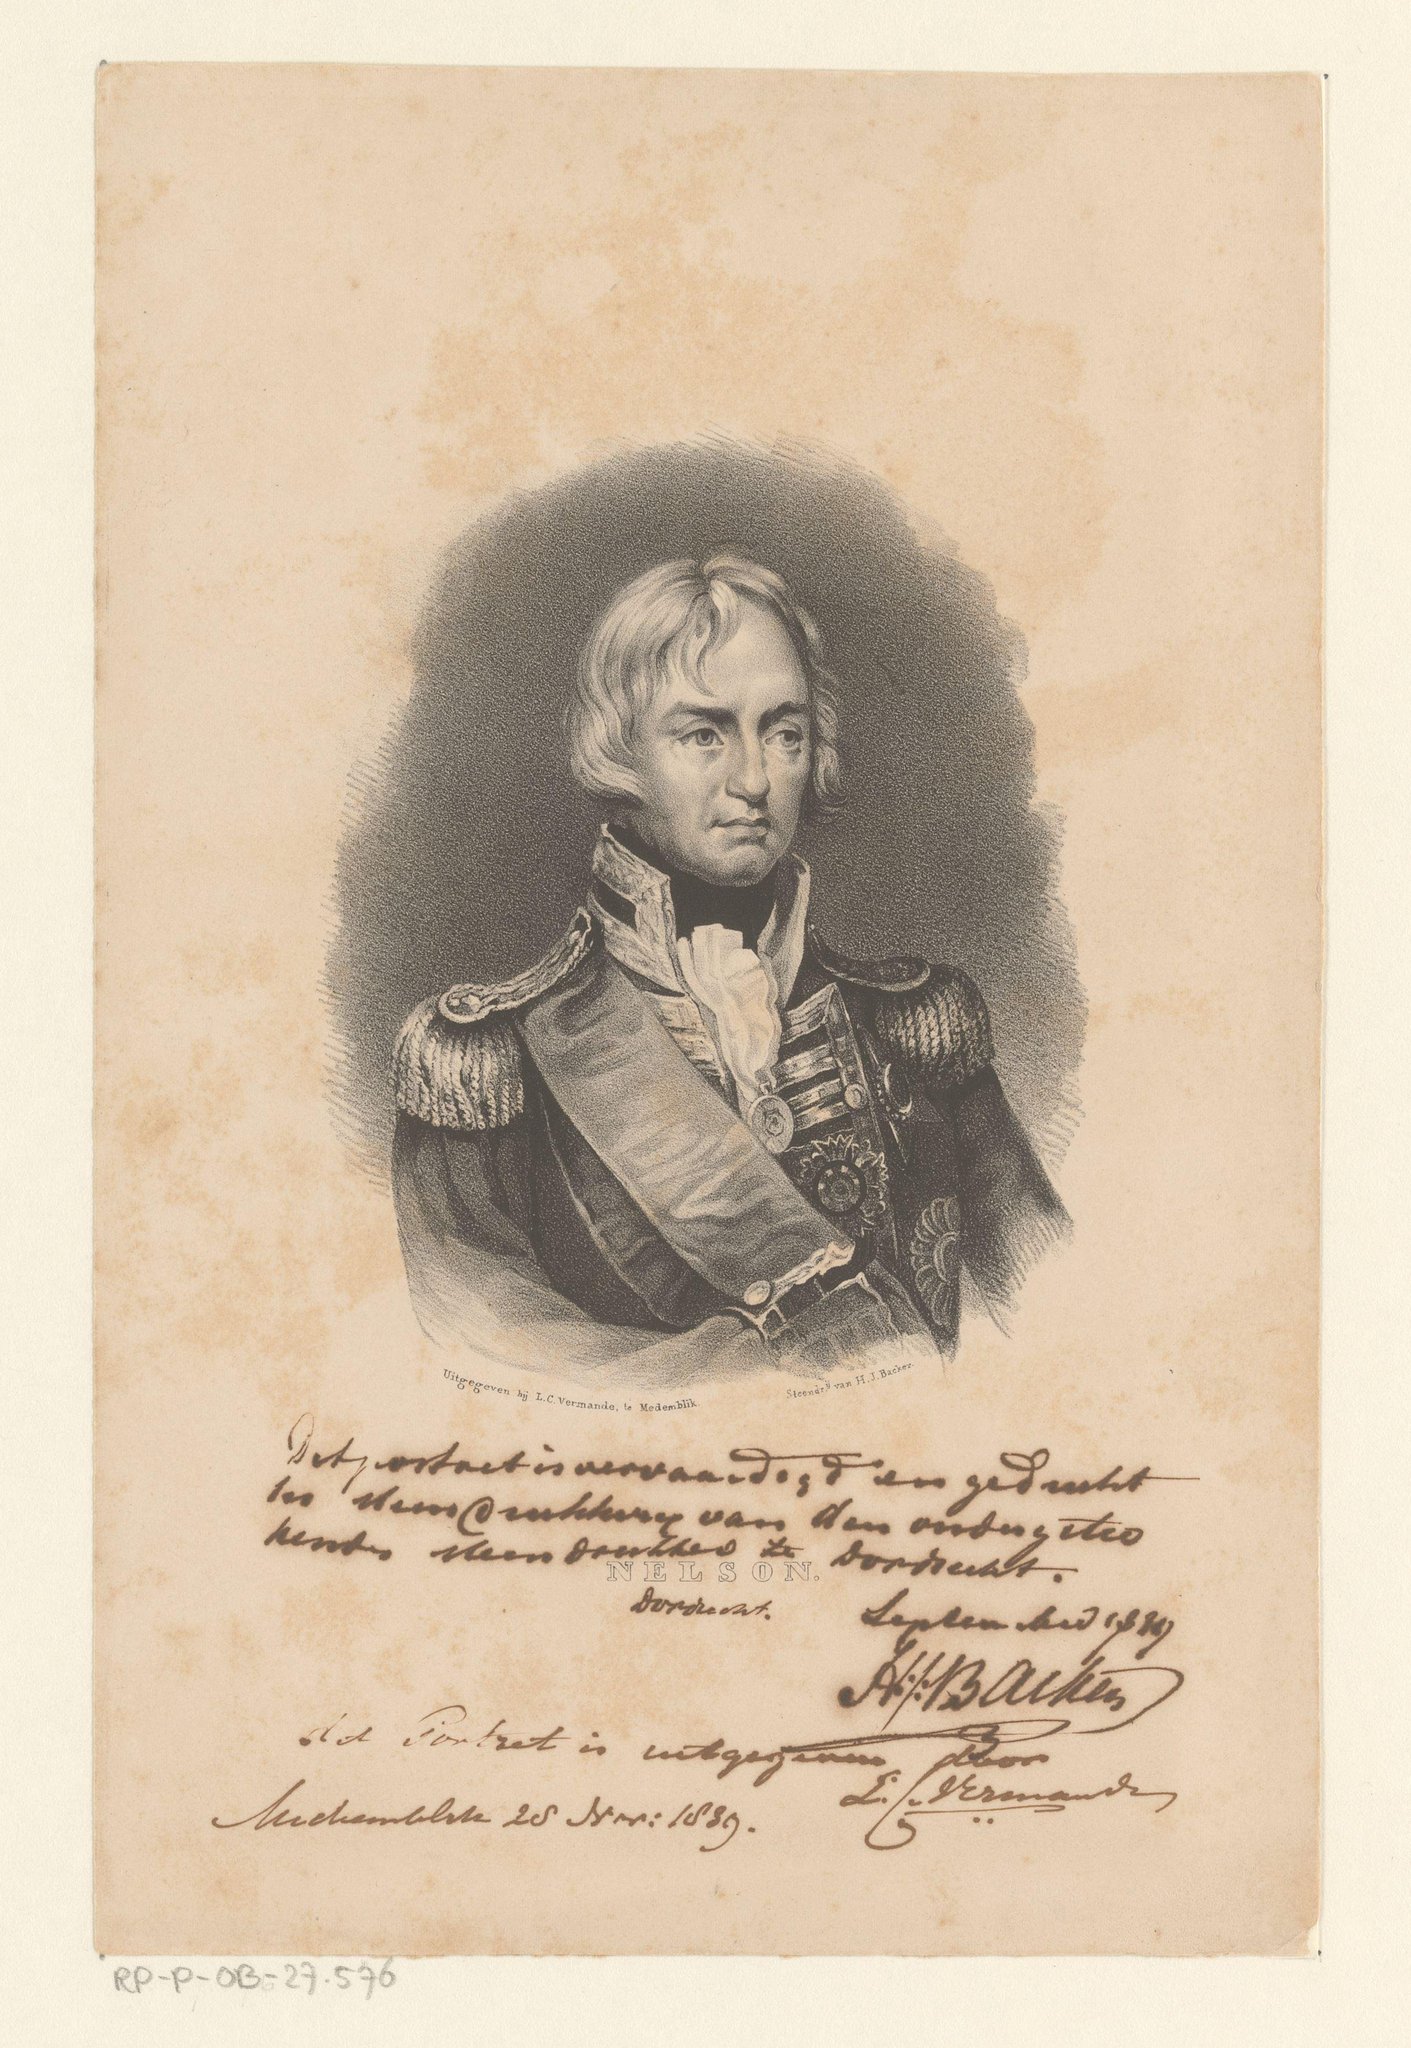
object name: print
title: Portret van admiraal Nelson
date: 1839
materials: paper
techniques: lithograph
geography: medemblik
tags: horatio nelson (hertog van bronte), historical persons, (military) uniforms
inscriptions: : ‘Dit portret is vervaardigd en gedrukt / in den drukkerij van den ondergetek / ende steendrukker te Dordrecht. / Dordrecht September 1839 H. J. Backer / Dit portret is uitgegeven door / L. C. Vermande / Medemblik 28 (...) 1839.’, collector's mark: Lugt 2228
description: Aan deze tweede staat zijn de naam van de geportretteerde en de uitgever toegevoegd. Ook is zijn uniform verder uitgewerkt.